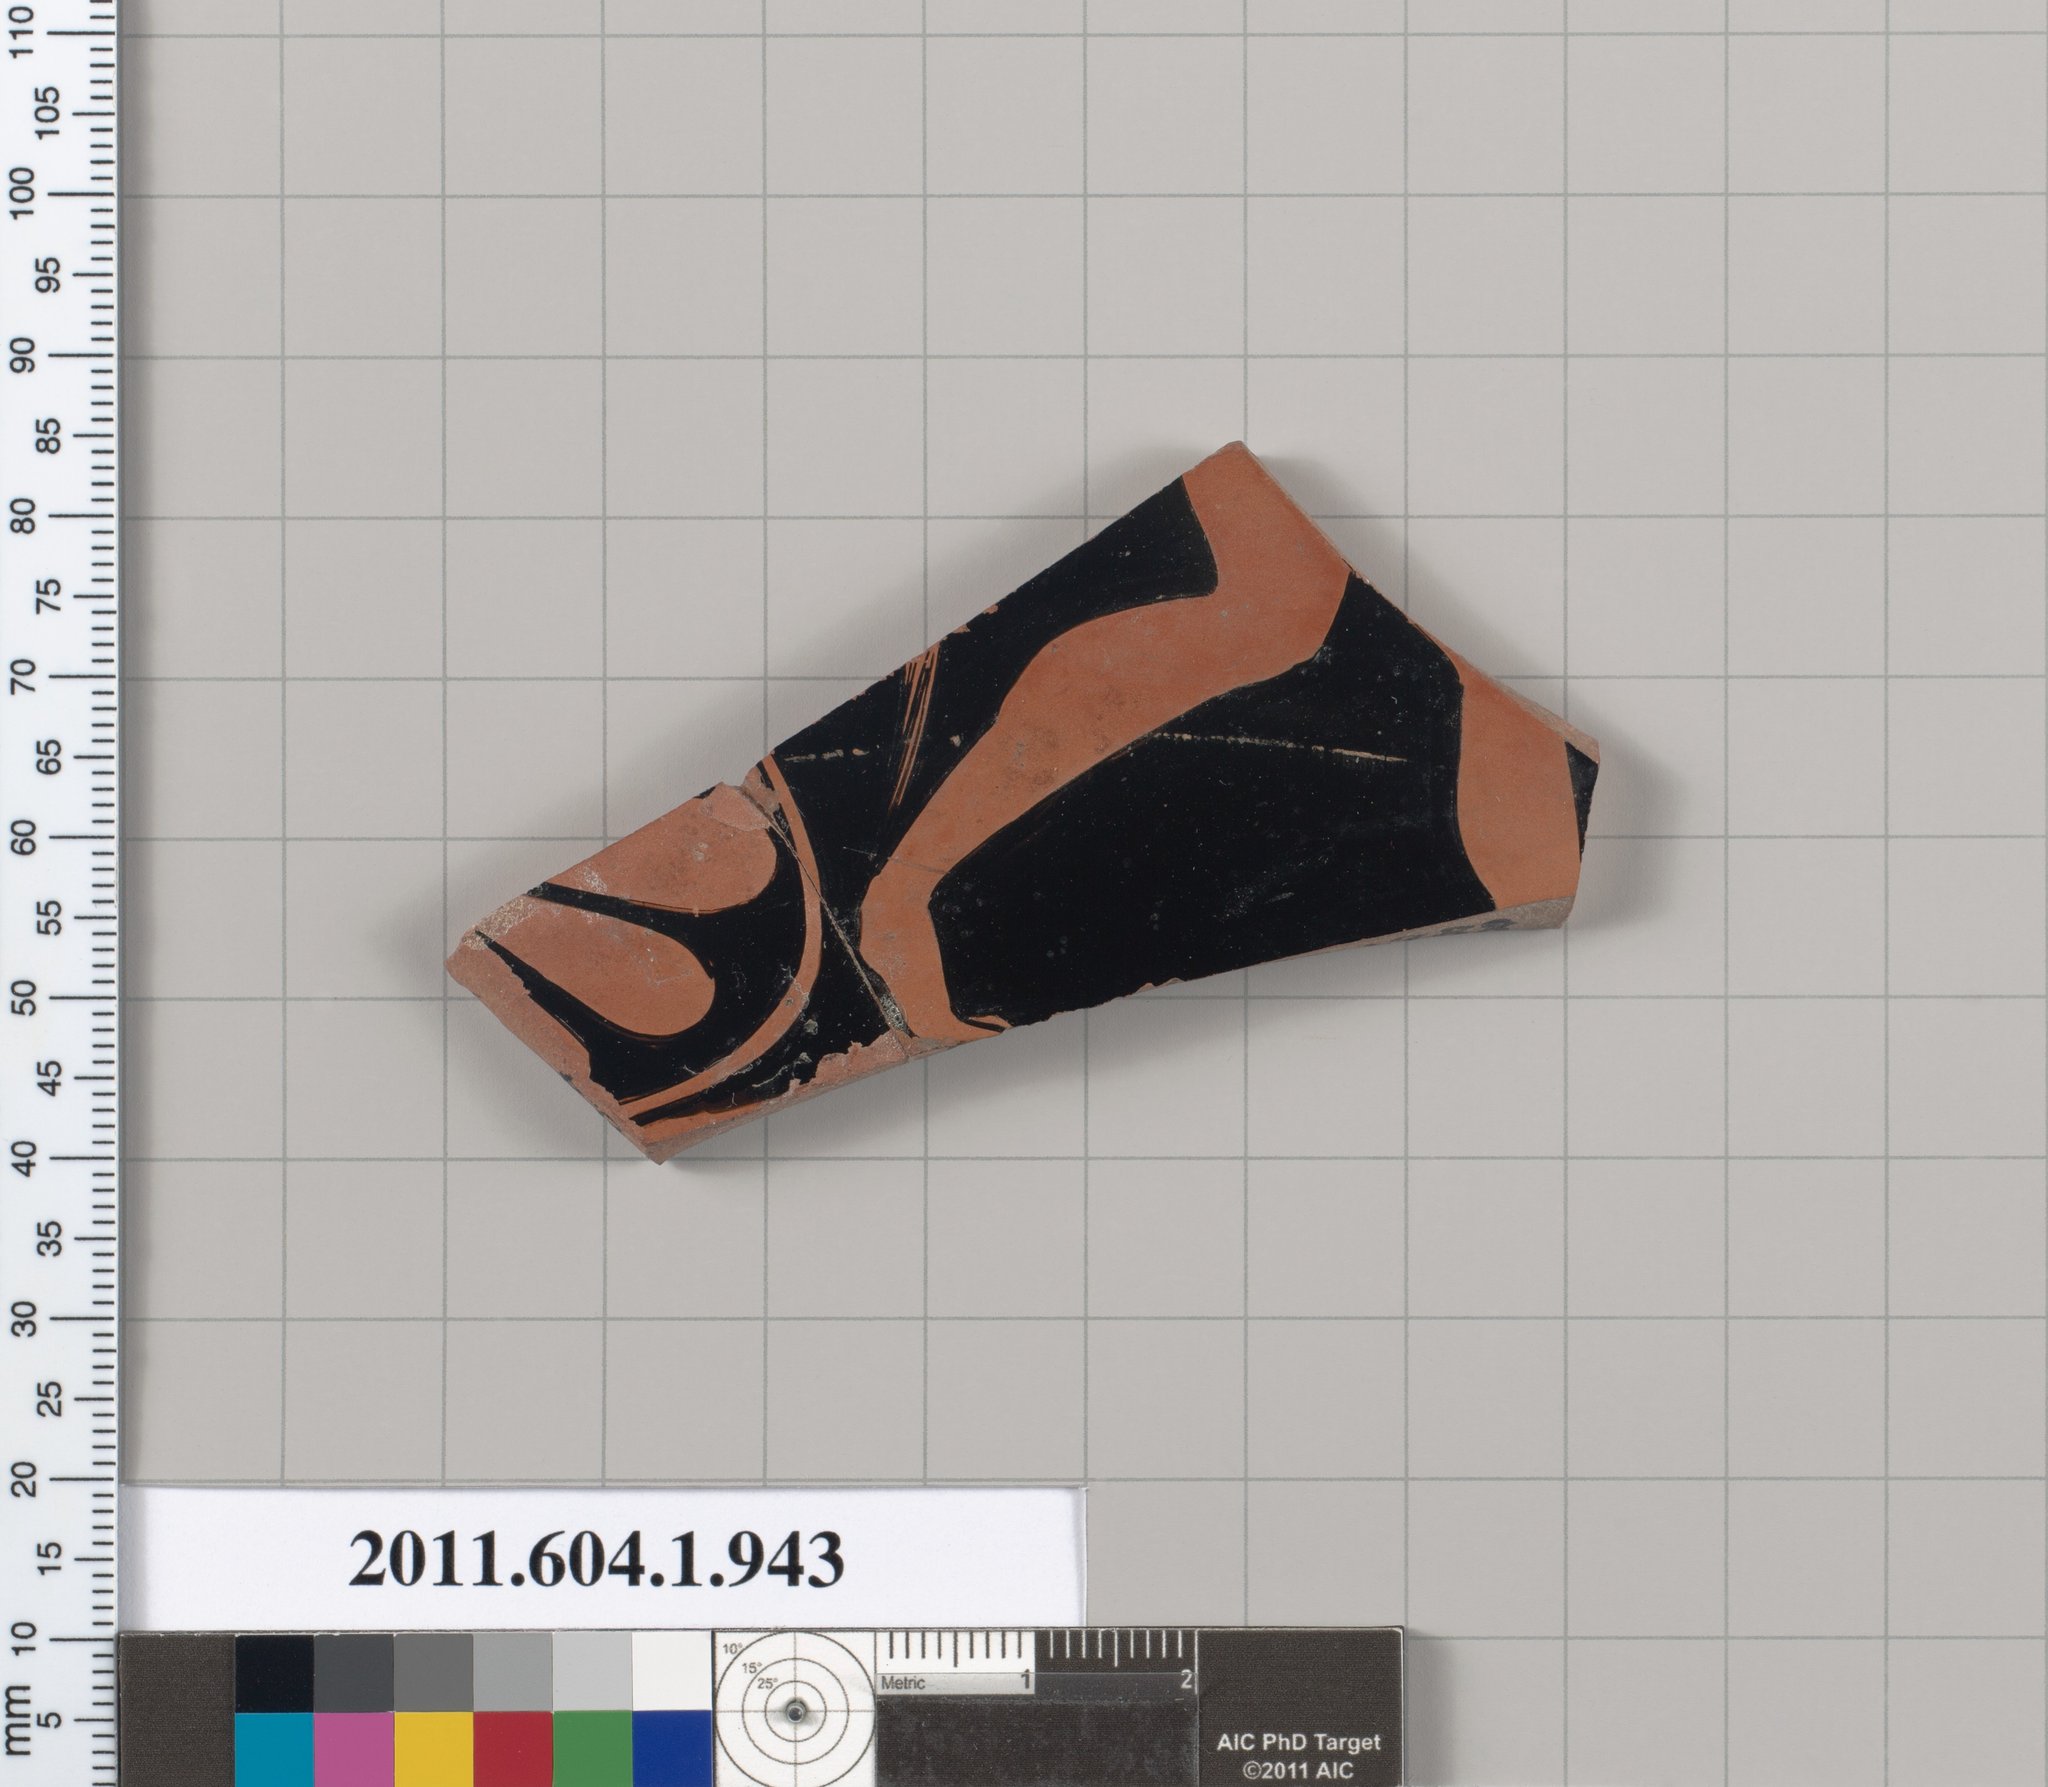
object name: kylix fragment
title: Terracotta fragment of a kylix (drinking cup)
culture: greek, attic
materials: terracotta